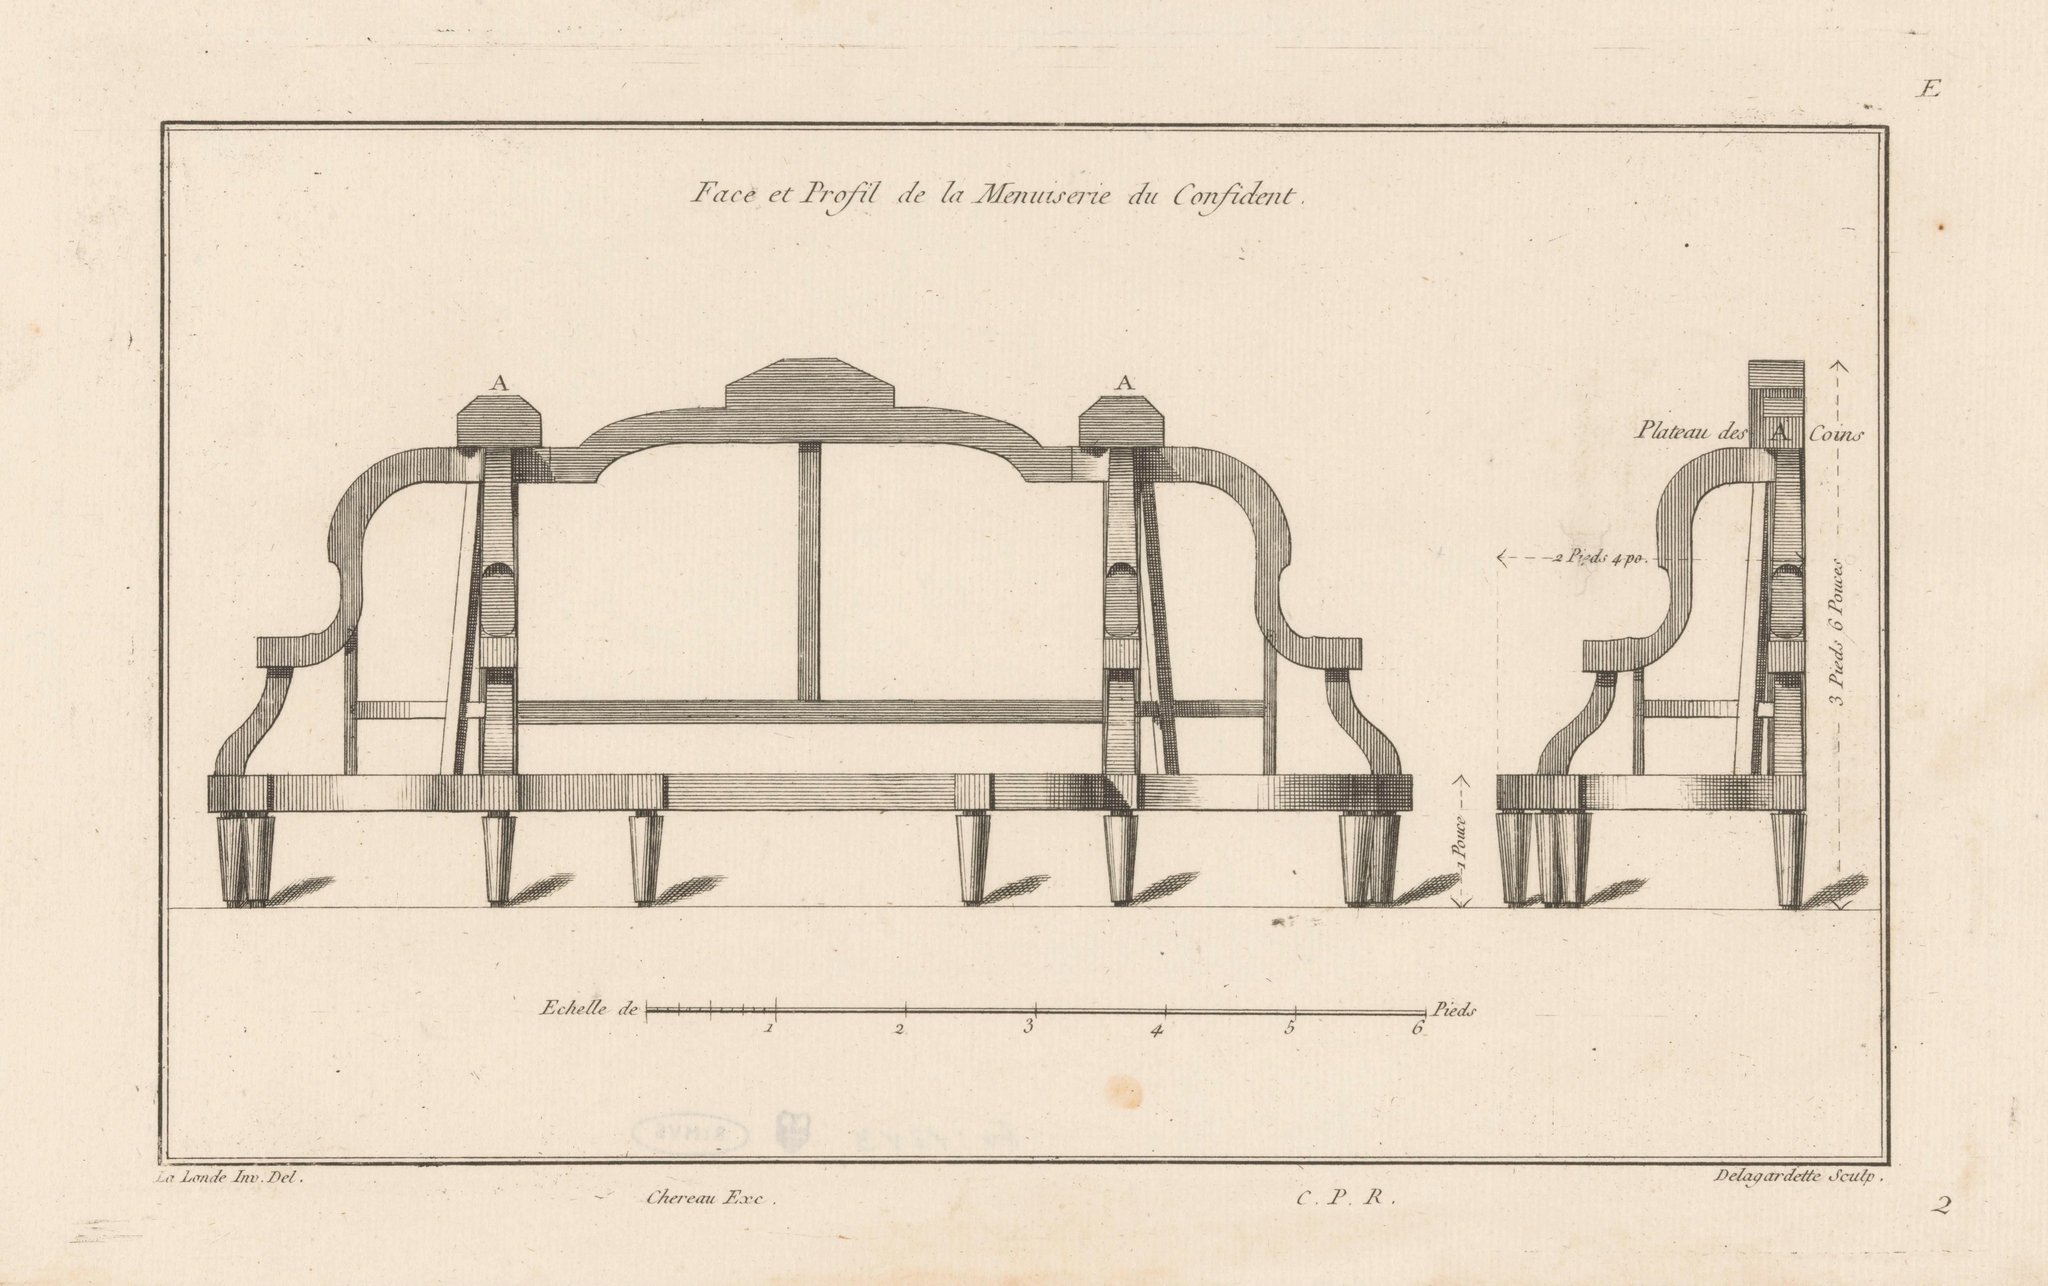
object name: ornament print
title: Face et Profil de la Menuiserie du Confident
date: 1784-1785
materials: paper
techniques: etching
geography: paris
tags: bench, timber framing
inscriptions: collector's mark: Lugt 2760, collector's mark: Lugt 2228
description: Vooraanzicht en profiel van een houten frame van een bank bestaand uit drie compartimenten.